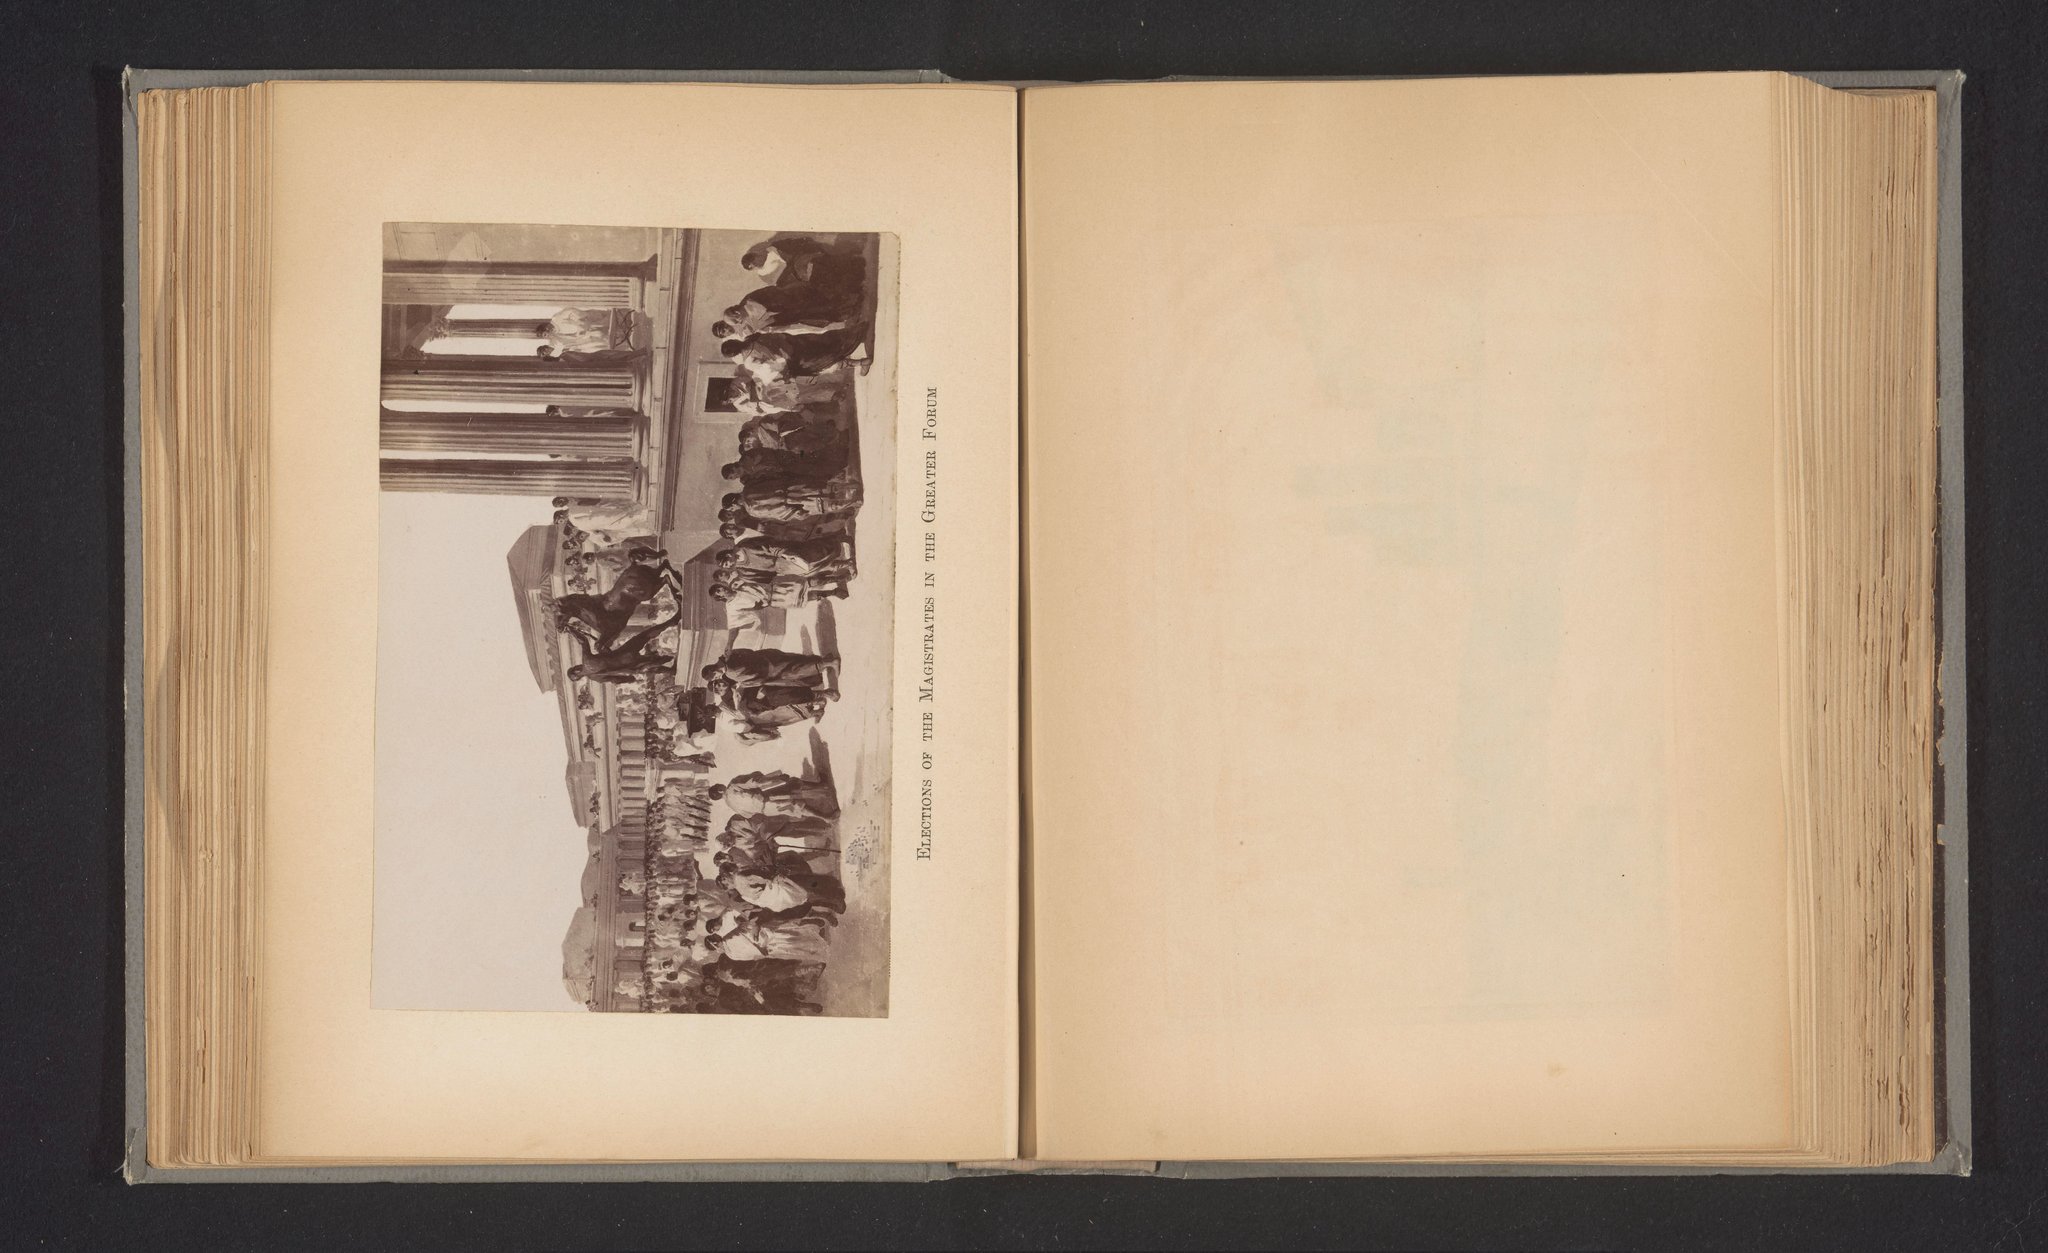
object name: photograph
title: Fotoreproductie van een gezicht op de verkiezingen van de magistraten in het Forum te Pompeï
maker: Anonymous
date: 1890-1895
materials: photographic support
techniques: albumen print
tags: civic architecture; edifices; dwellings, pompeii